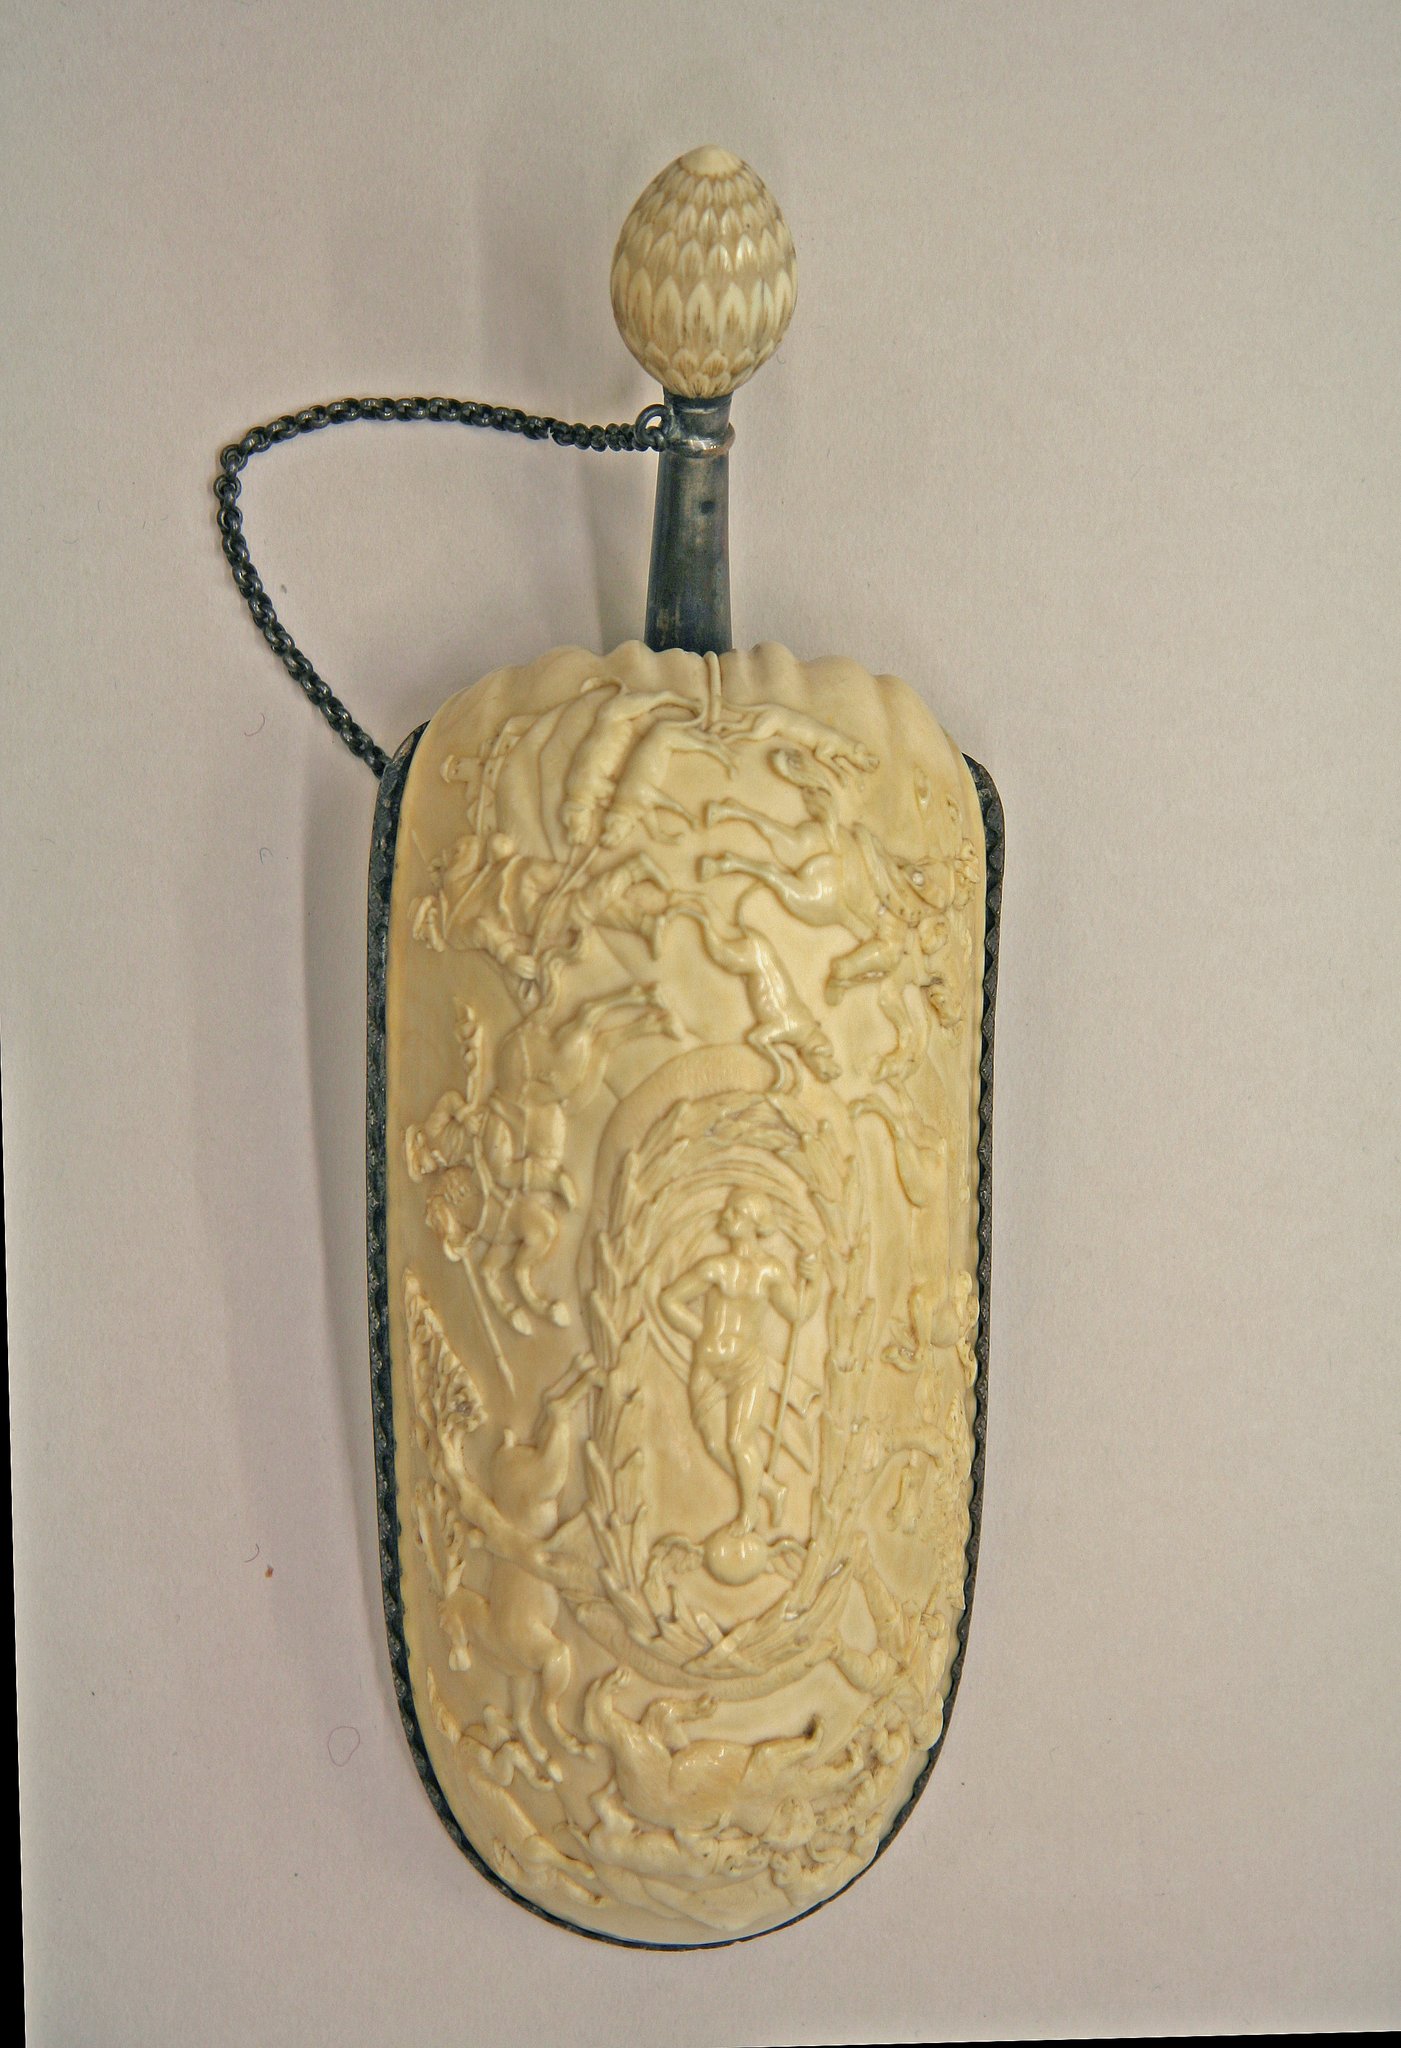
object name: powder flask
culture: bohemian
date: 1801-1850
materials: ivory, silver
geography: czech republic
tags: animals,hunting,horses